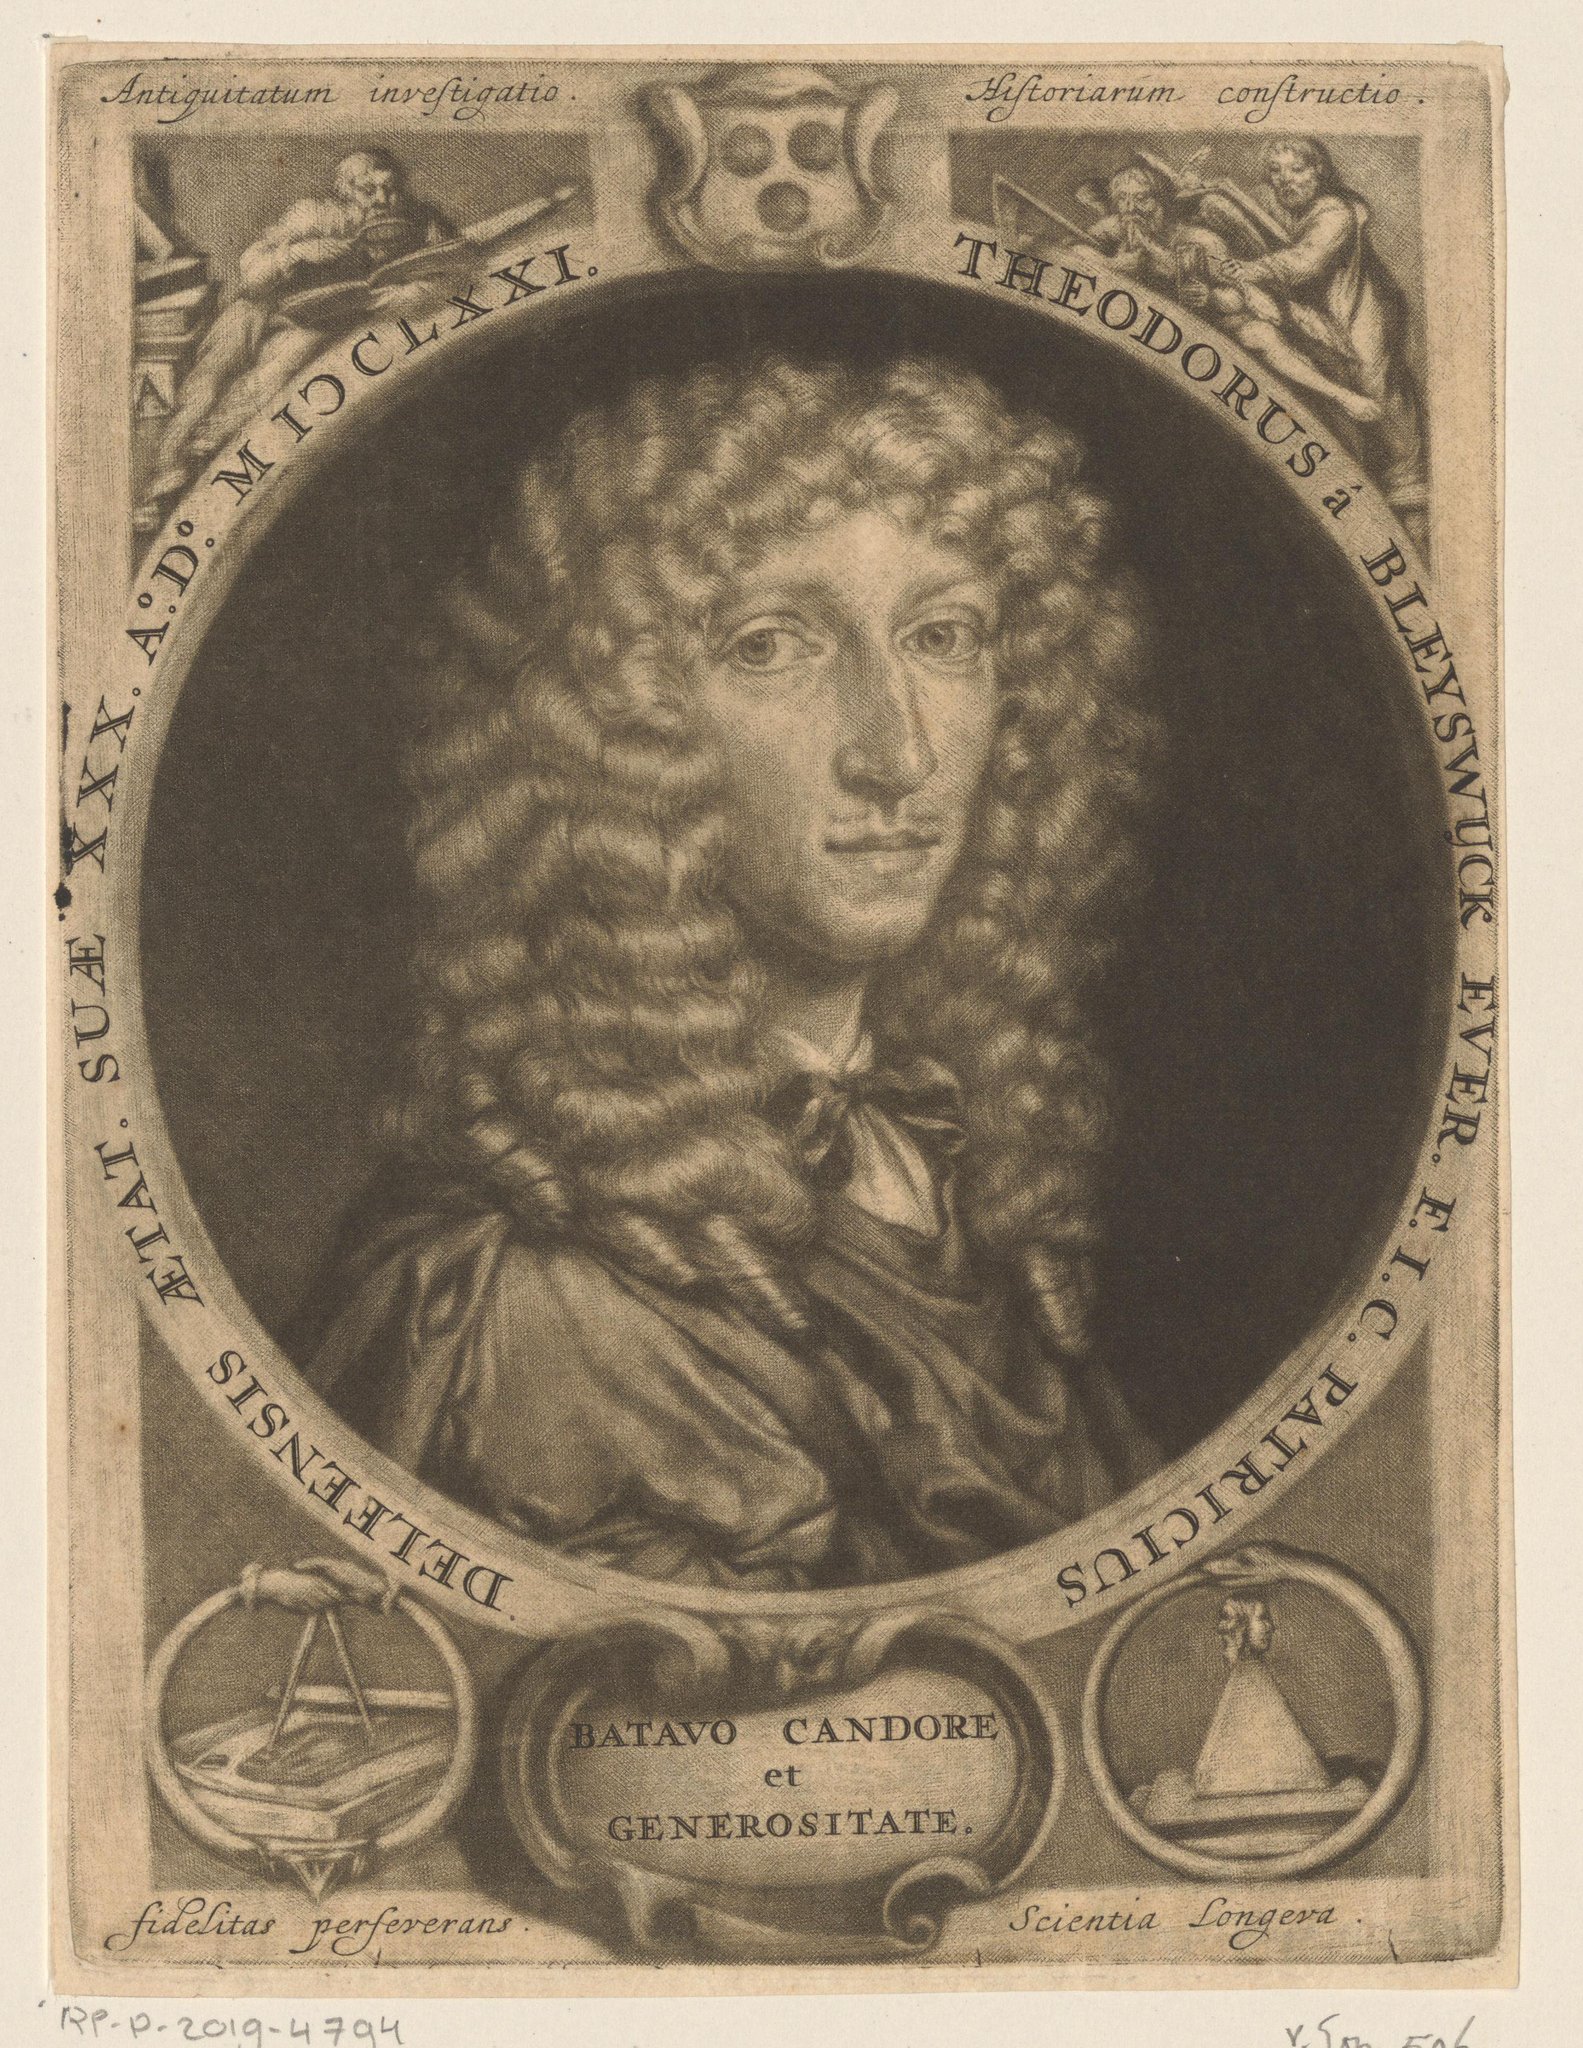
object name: print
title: Portret van Dirck Evertsz. van Bleyswijck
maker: jan verkolje (i)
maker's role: draughtsman, painter, print maker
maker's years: 1650-1693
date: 1671-1693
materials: paper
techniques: engraving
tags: dirck evertsz. van bleyswijck, historical persons, compasses, 'historia'; 'historia' (ripa), father time, man with wings and scythe